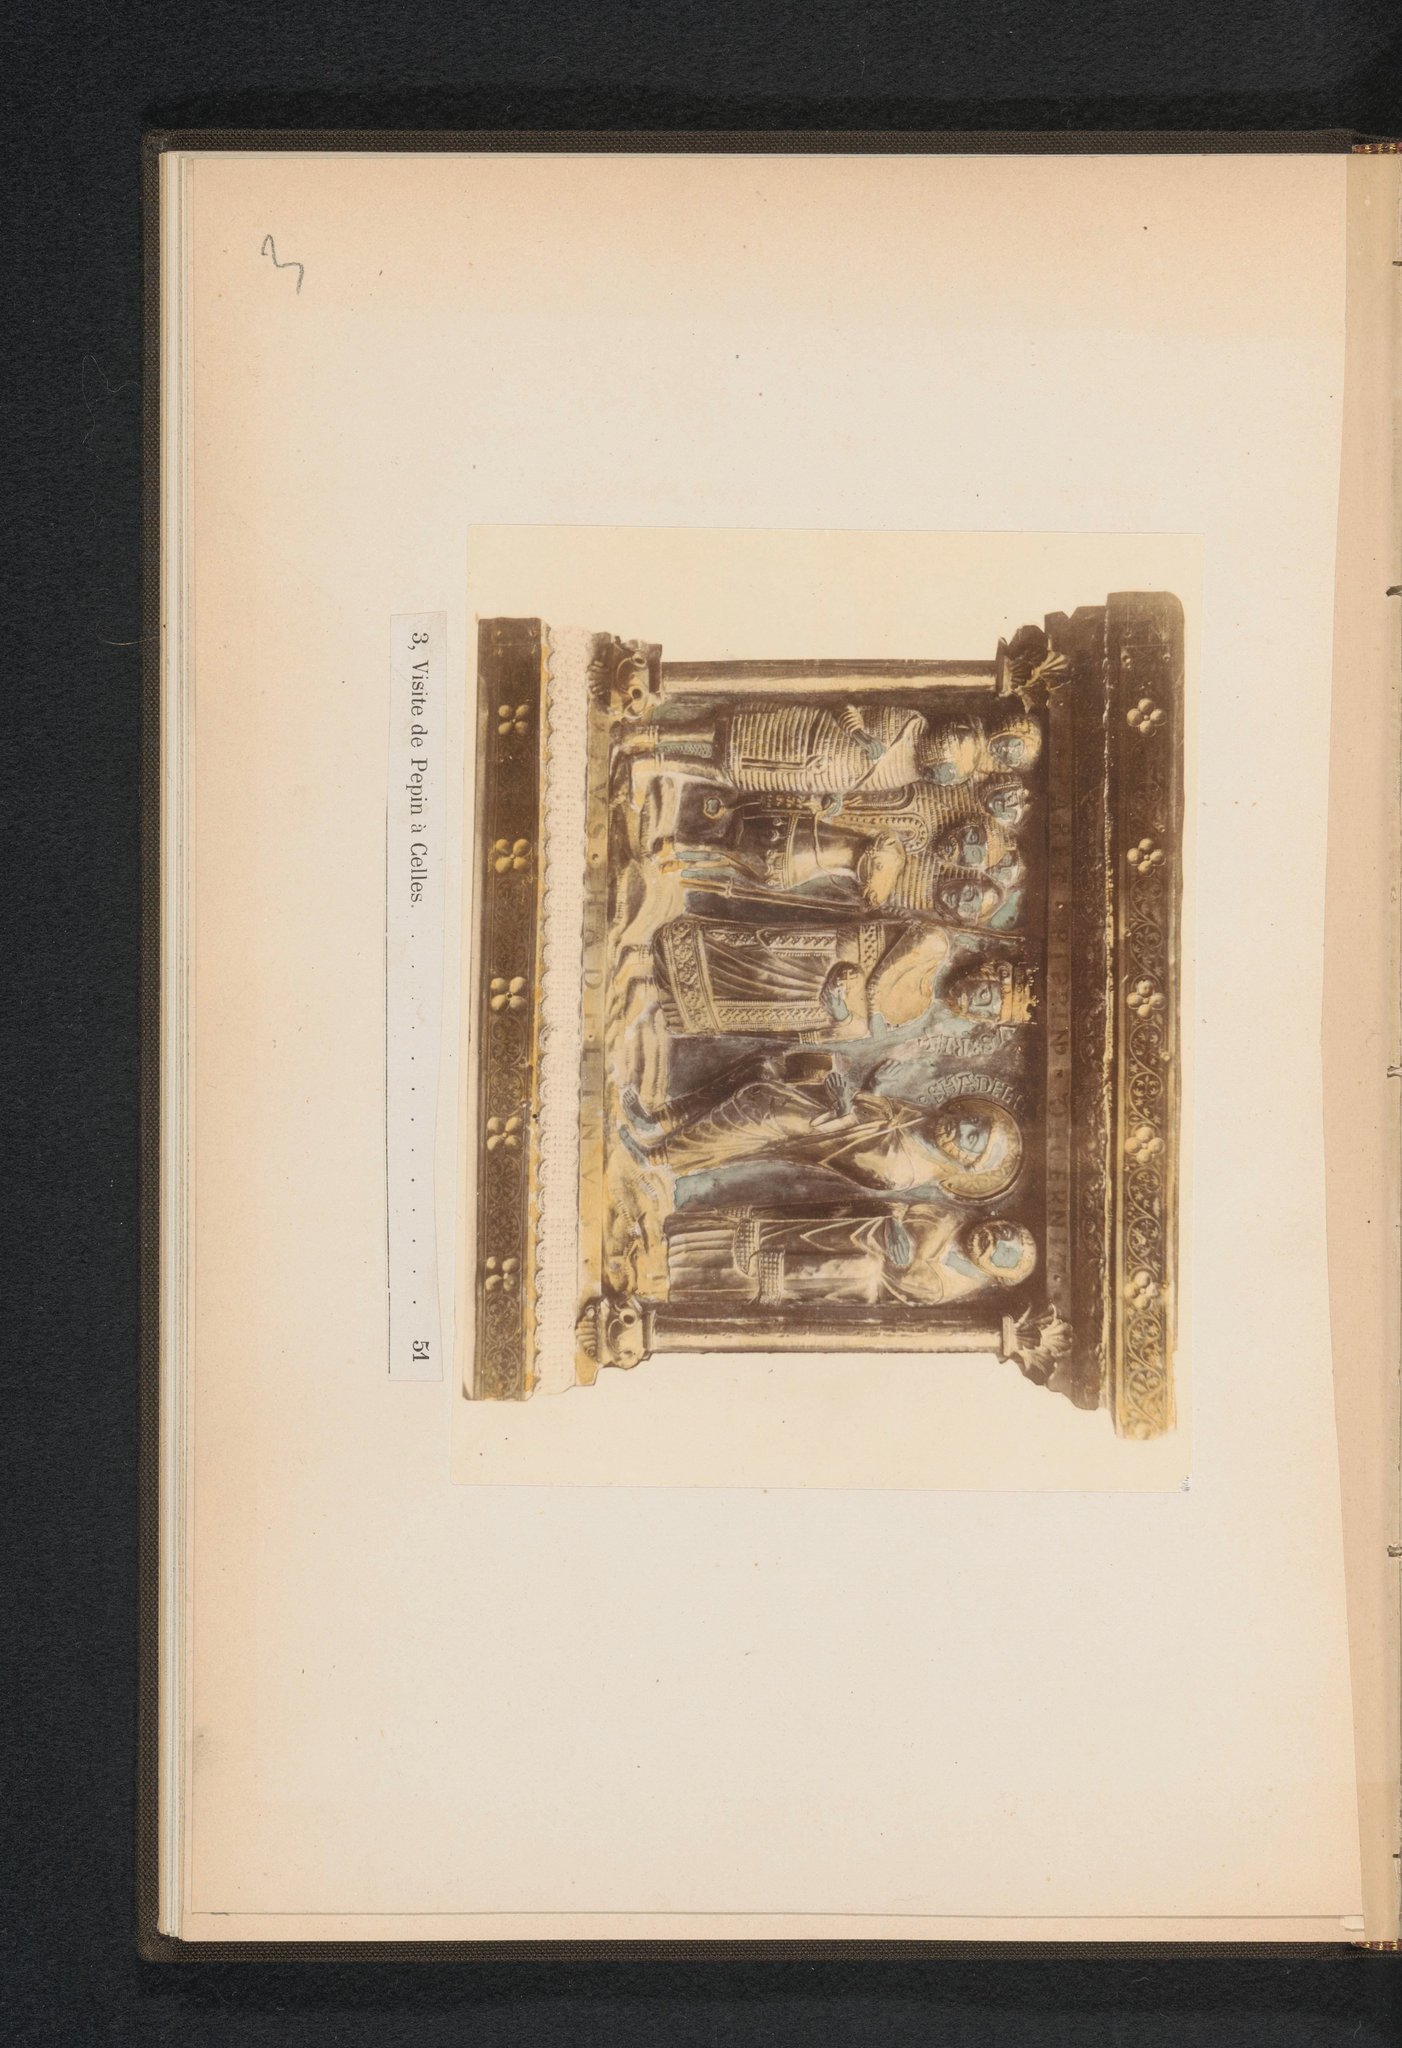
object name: page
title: Reliëf van het bezoek van koning Pepijn aan Celles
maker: Anonymous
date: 1877-1882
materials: photographic support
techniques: albumen print, hand coloring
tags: relics (and reliquaries), sculpture (+ relief ~ sculpture)